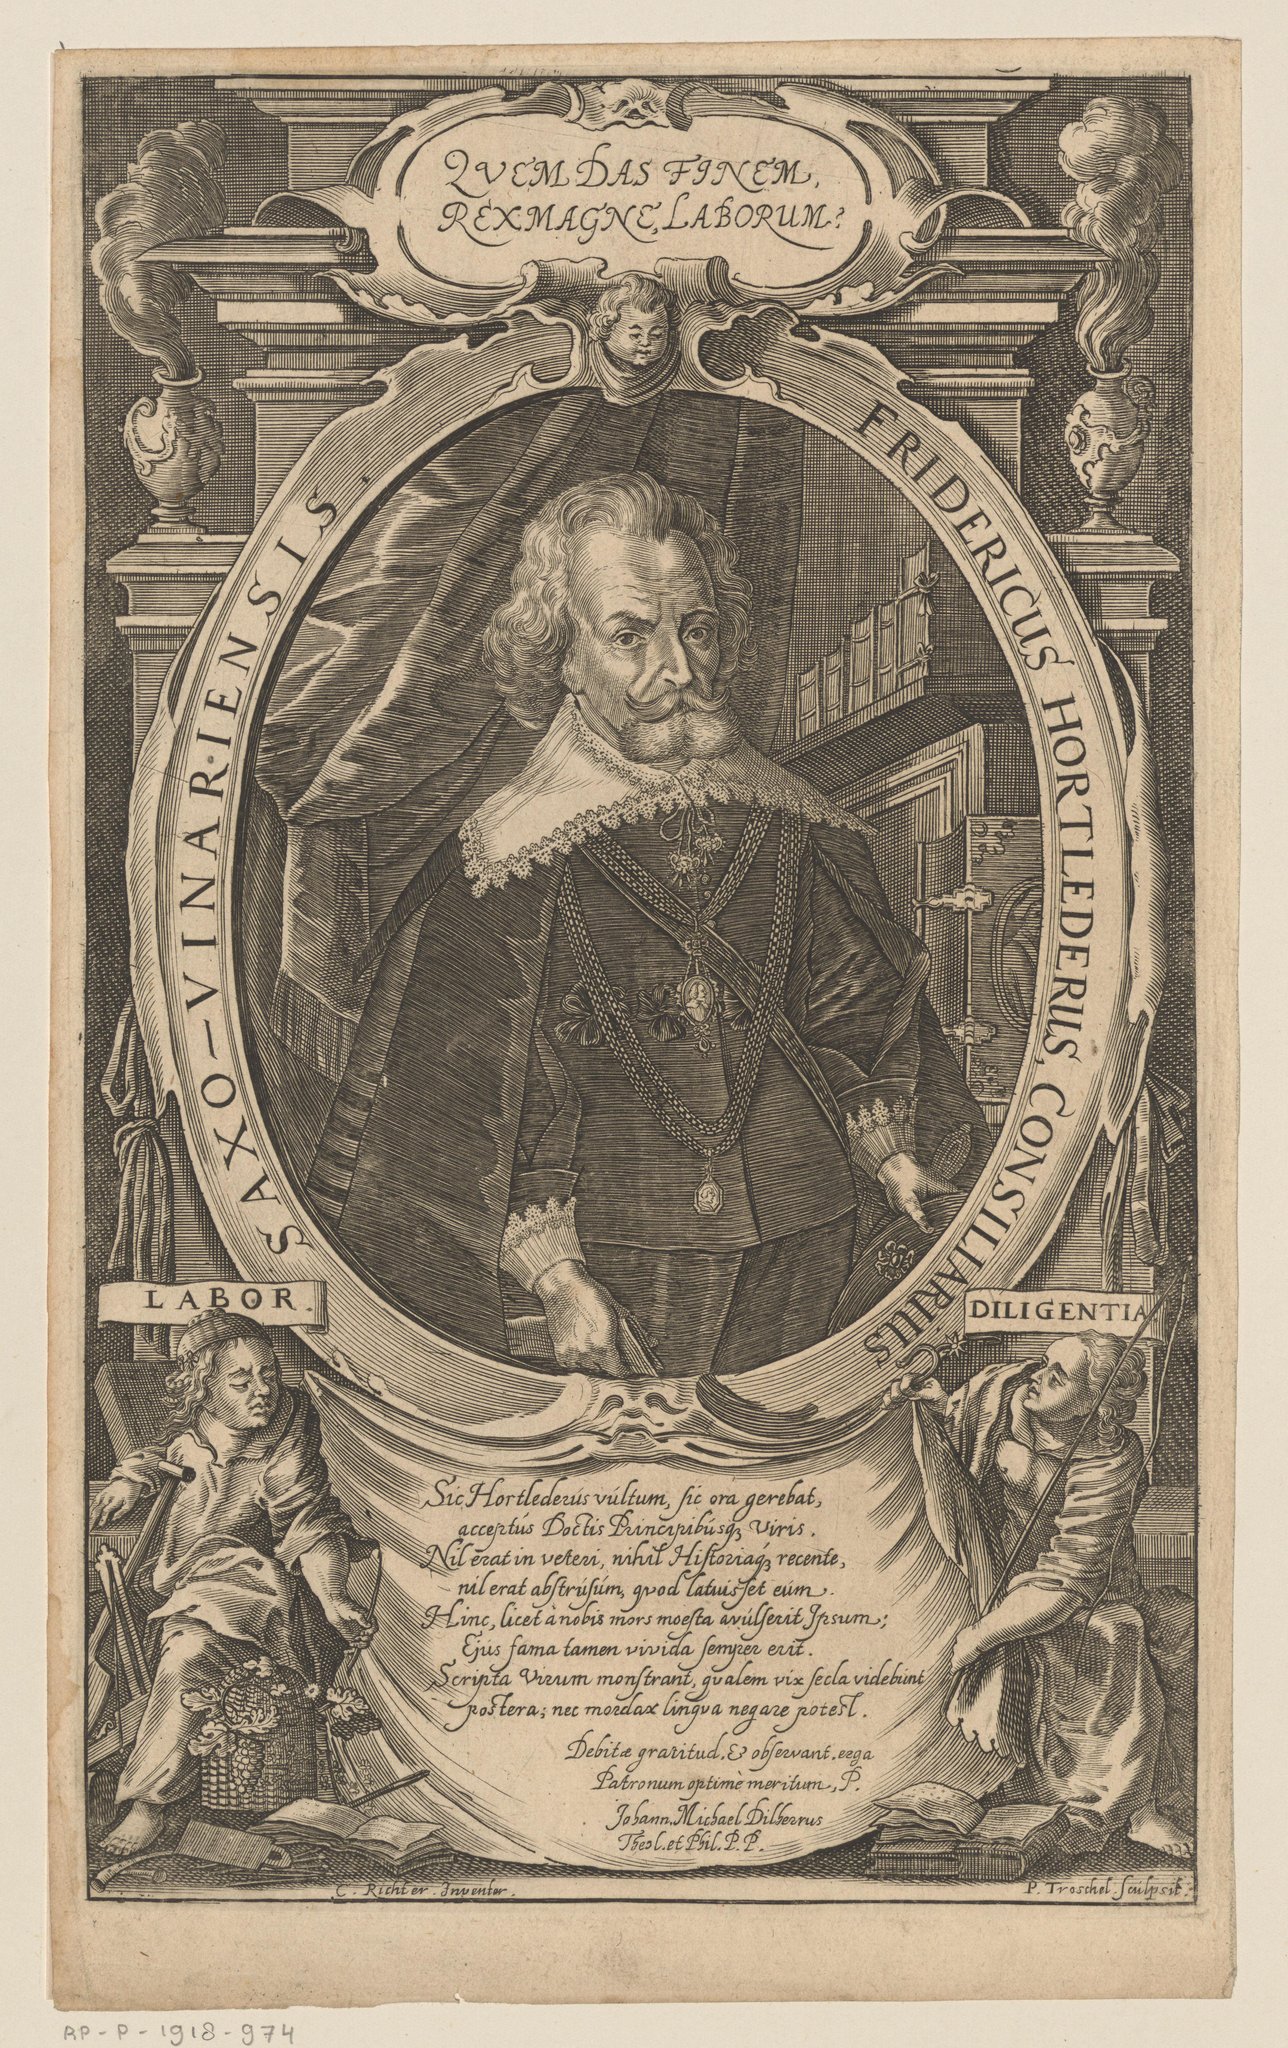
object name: print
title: Portret van Friedrich Hortleder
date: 1630-1670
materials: paper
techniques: engraving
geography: gotha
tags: historical persons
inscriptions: collector's mark: Lugt 2233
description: Prent gebruikt in: Hortleder, Friedrich. Der Römischen Kaiser- und Königlichen Majesteten (...). Gotha: Wolfgang Endter, 1645.